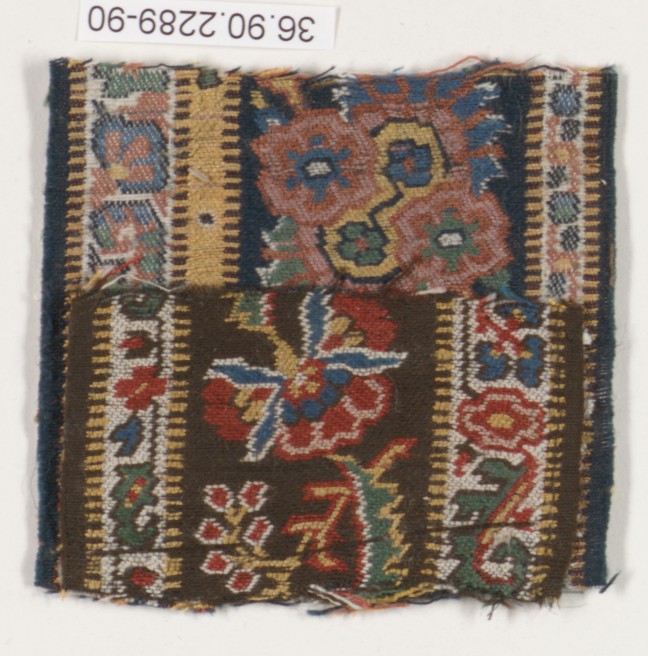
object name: border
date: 1801-1900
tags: flowers